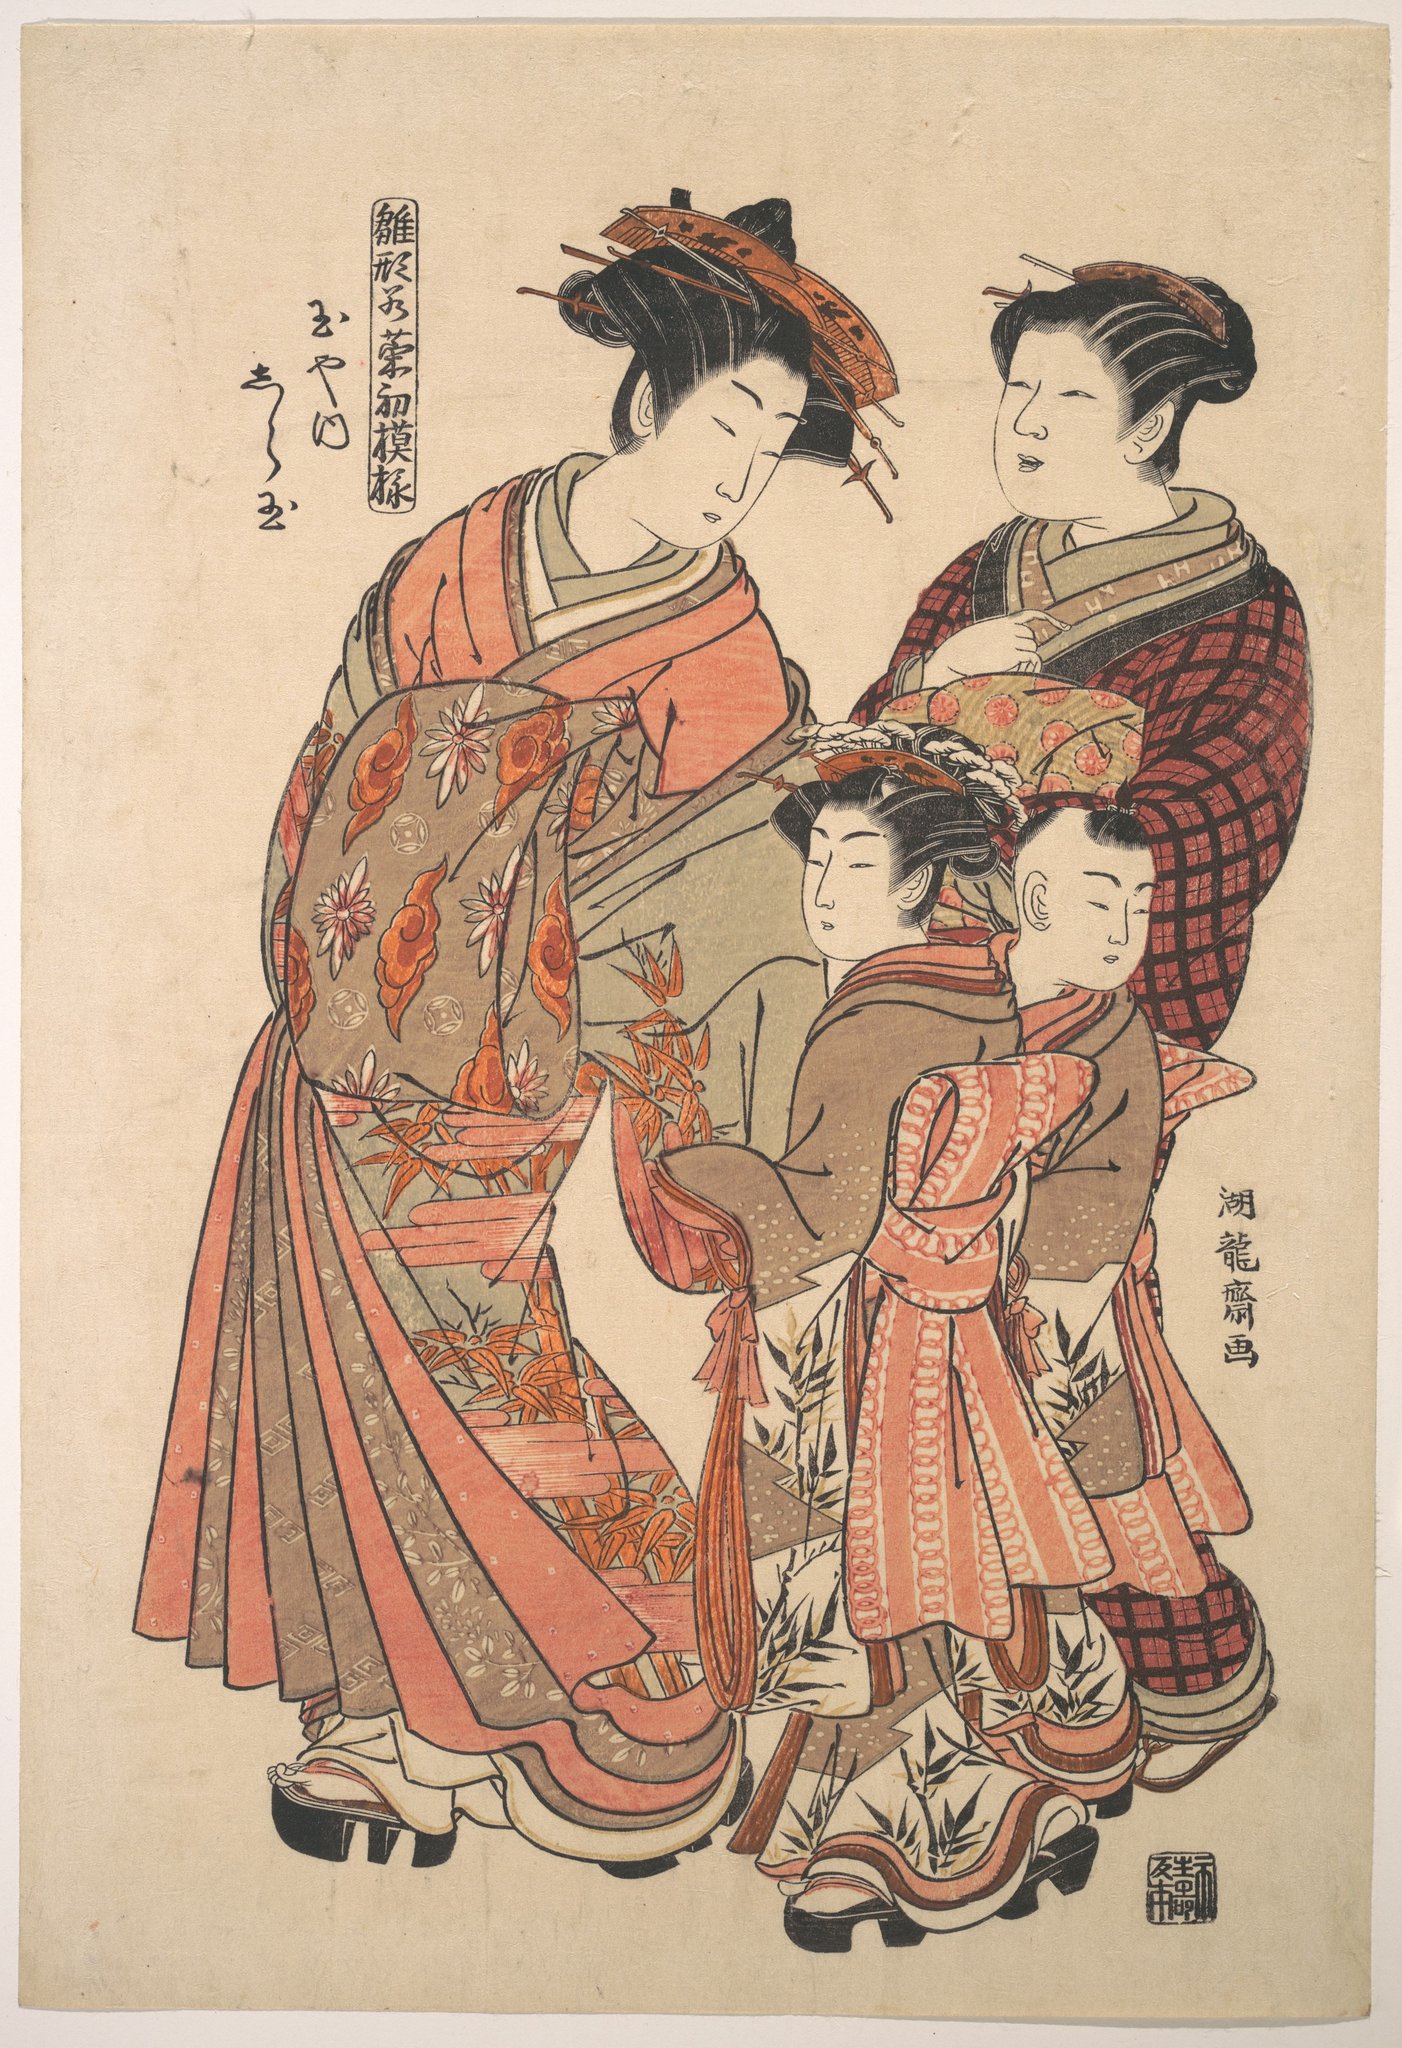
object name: print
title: The Courtesan Shiratama of the Tamaya Brothel, from the series “A Pat-tern Book of the Year’s First Designs, Fresh as Spring Herbs” (“Hinagata wakana hatsu moyō”)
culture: japanese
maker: isoda koryūsai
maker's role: artist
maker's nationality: japanese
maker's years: 1735-1790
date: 1777-1778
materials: ink, paper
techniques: woodblock print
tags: boys,girls,women